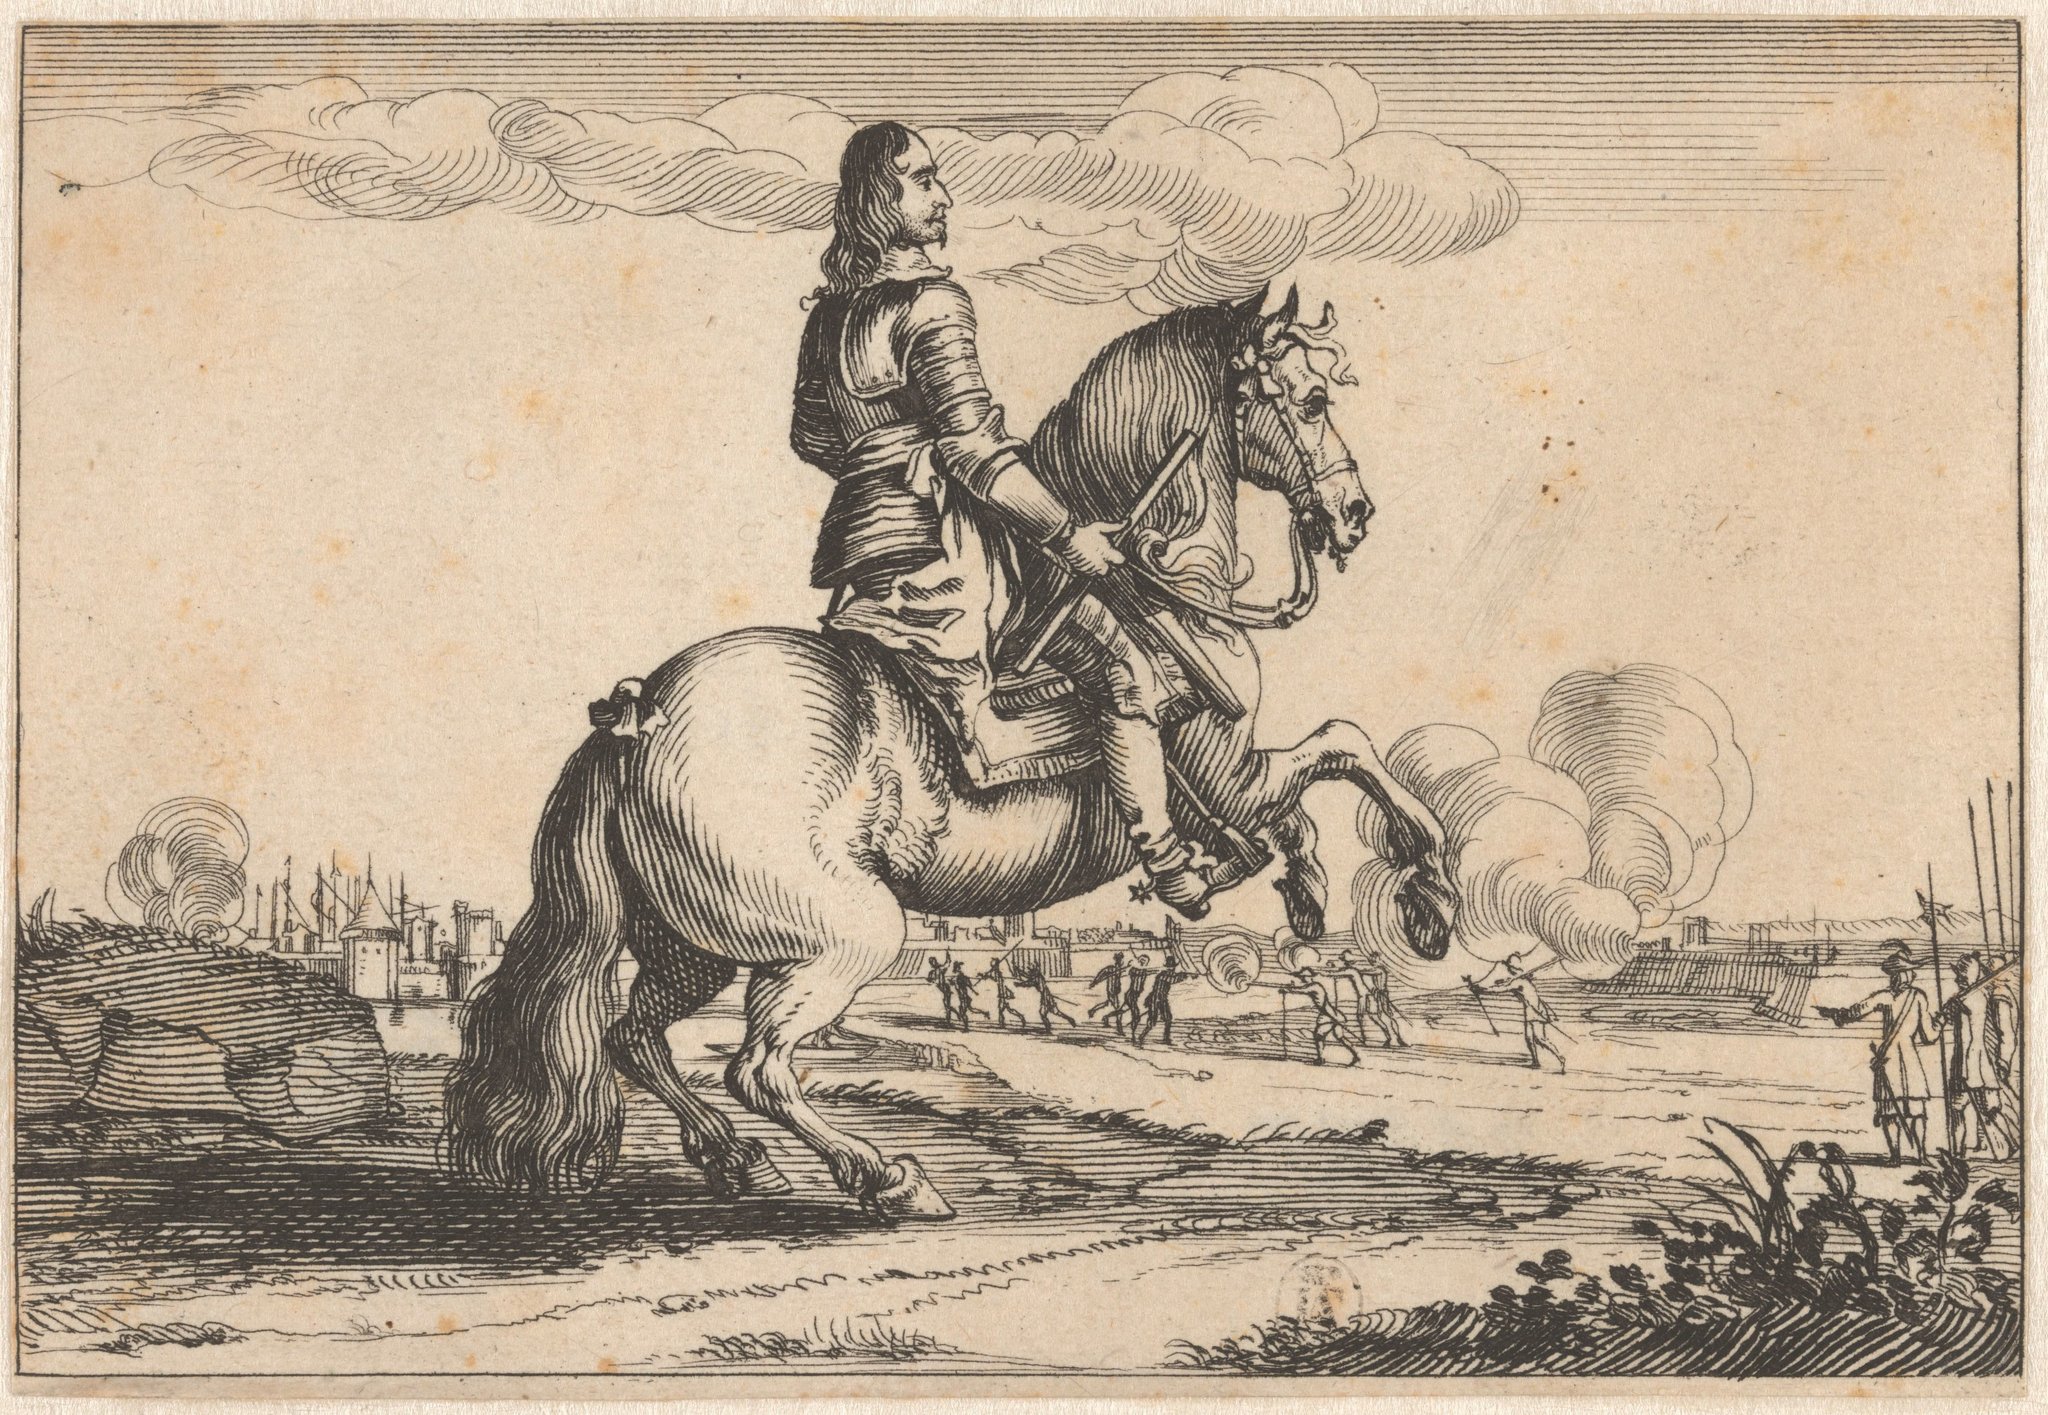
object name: print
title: Ruiter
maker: theodorus van kessel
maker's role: print maker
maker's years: 1620-1660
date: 1654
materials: paper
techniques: etching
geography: antwerp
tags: vienna, leopold willem van oostenrijk (landvoogd der zuidelijke nederlanden), riding a horse, ass, or mule; rider, horseman, commander-in-chief, general, marshal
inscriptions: collector's mark: Lugt 2760, collector's mark: Lugt 2228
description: Ruiter op steigerend paard, mogelijk Leopold Willem. Onderdeel van een serie van zes prenten over het leger van de landvoogd Leopold Willem, aartshertog van Oostenrijk.